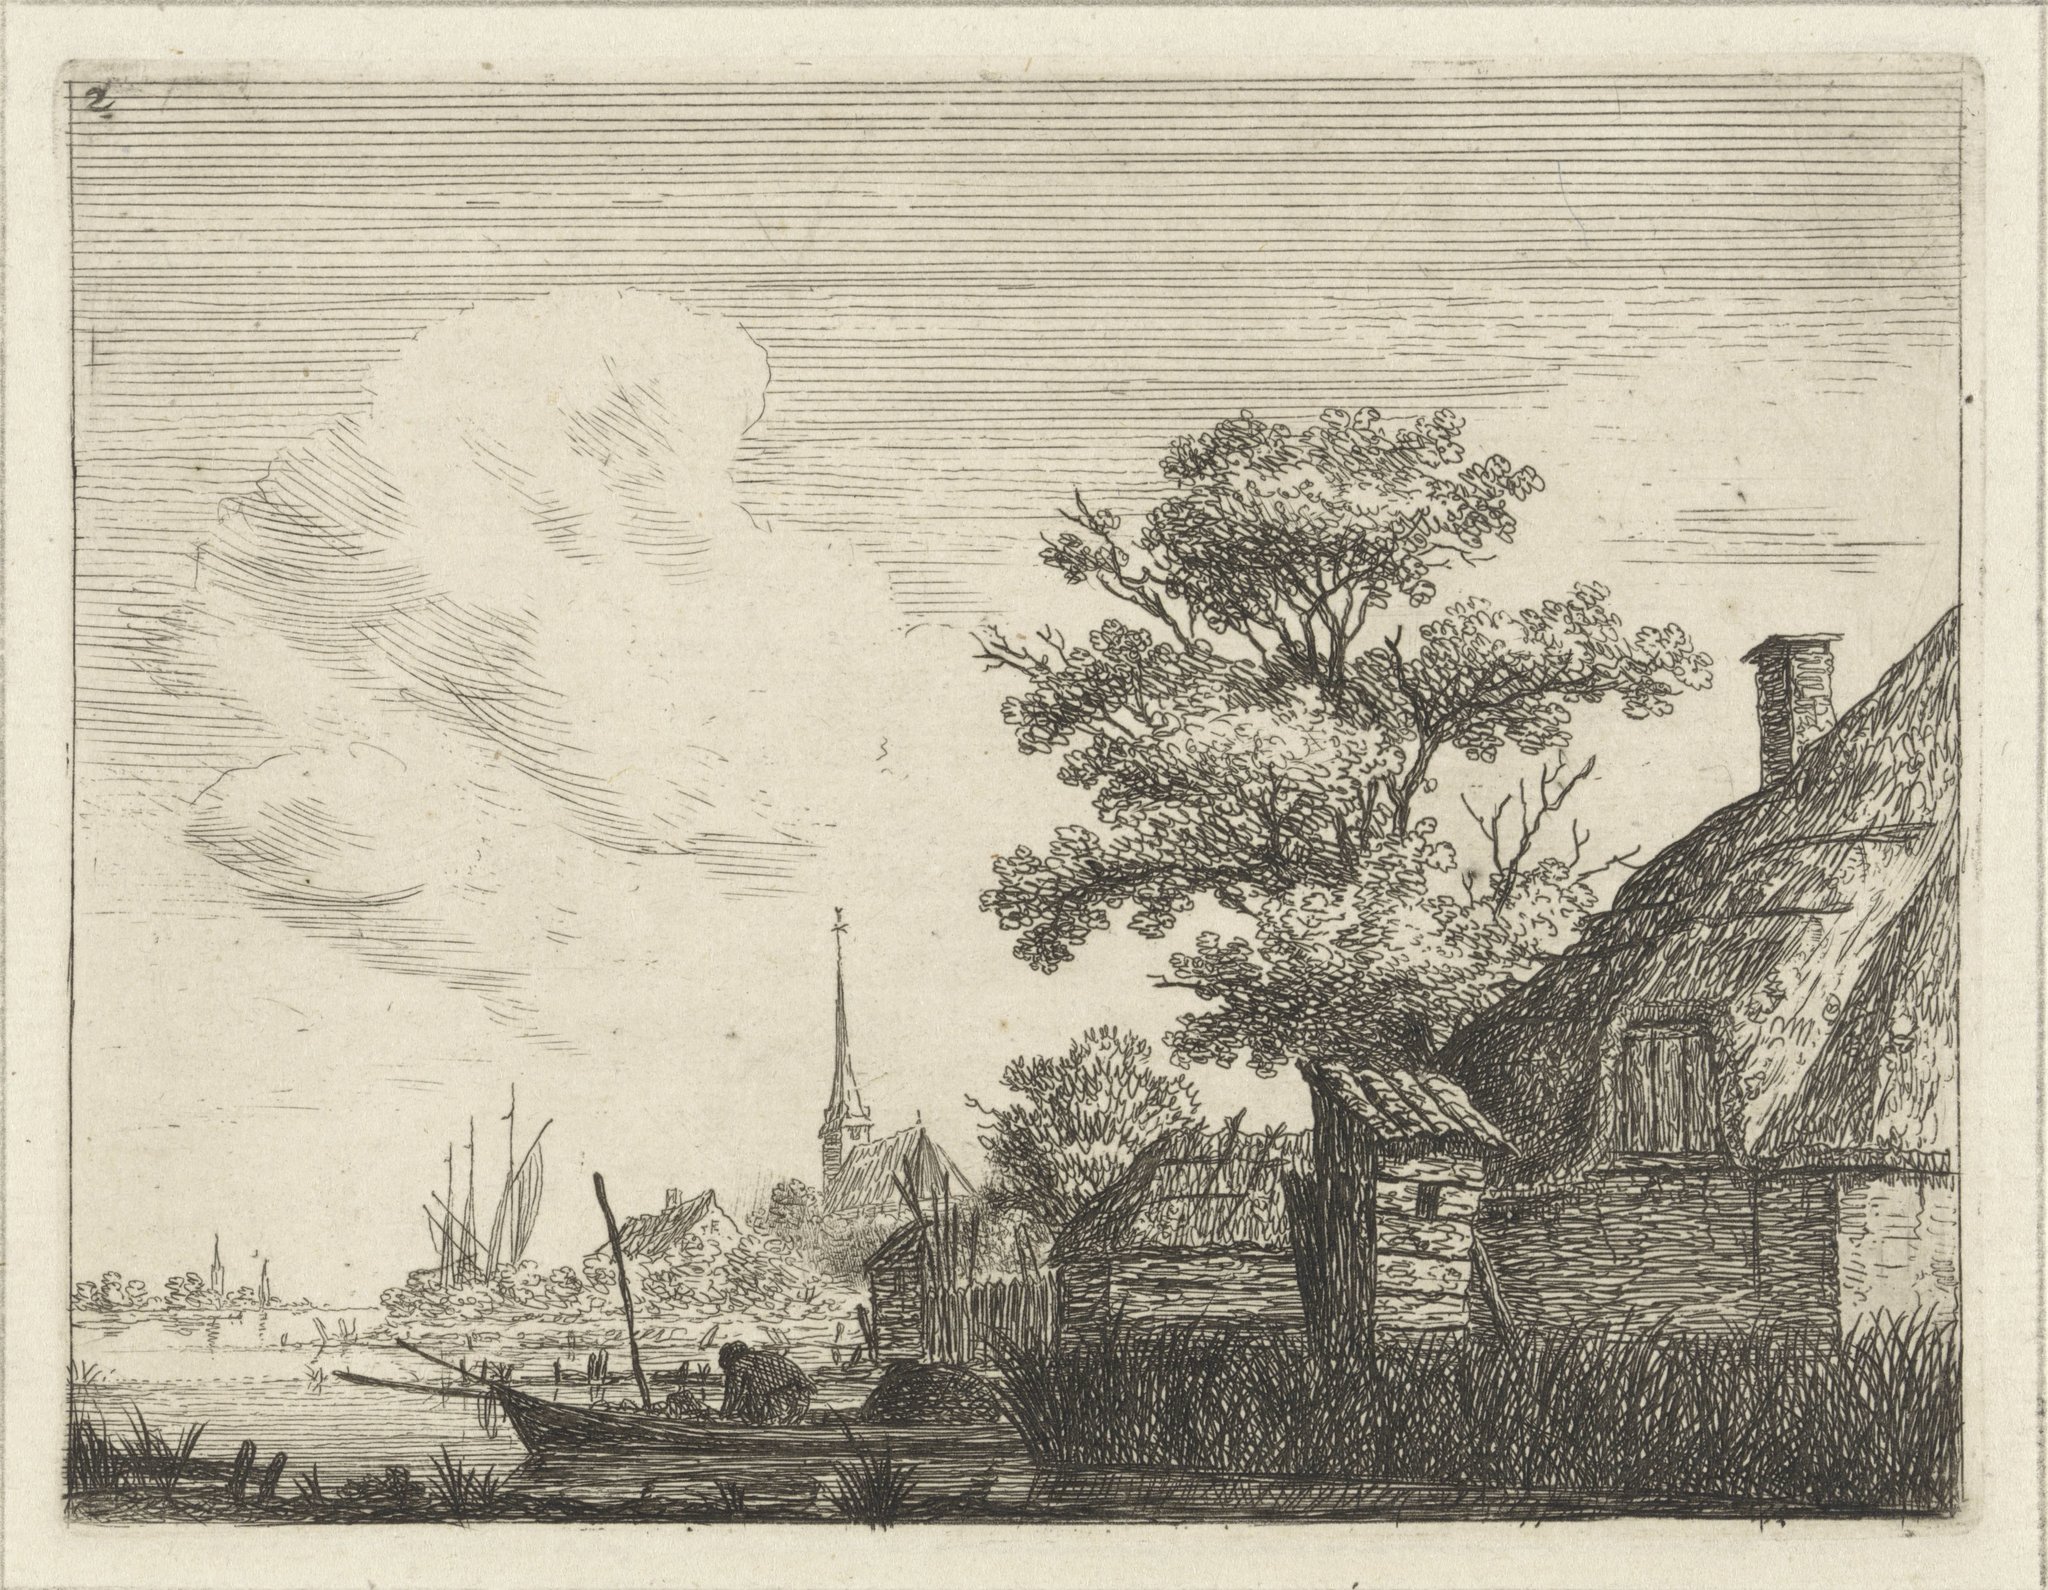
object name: print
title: Landschap met boerderij en dorp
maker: hendrik schwegman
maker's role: draughtsman, print maker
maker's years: 1761-1816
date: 1786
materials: paper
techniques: engraving, etching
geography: haarlem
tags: water course, rowing-boat, canoe, etc., farm or solitary house in landscape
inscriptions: collector's mark: Lugt 2228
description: Langs het water staat rechts een boerderij. Op de achtergrond een dorp met kerk. Op het water een visser in een boot.